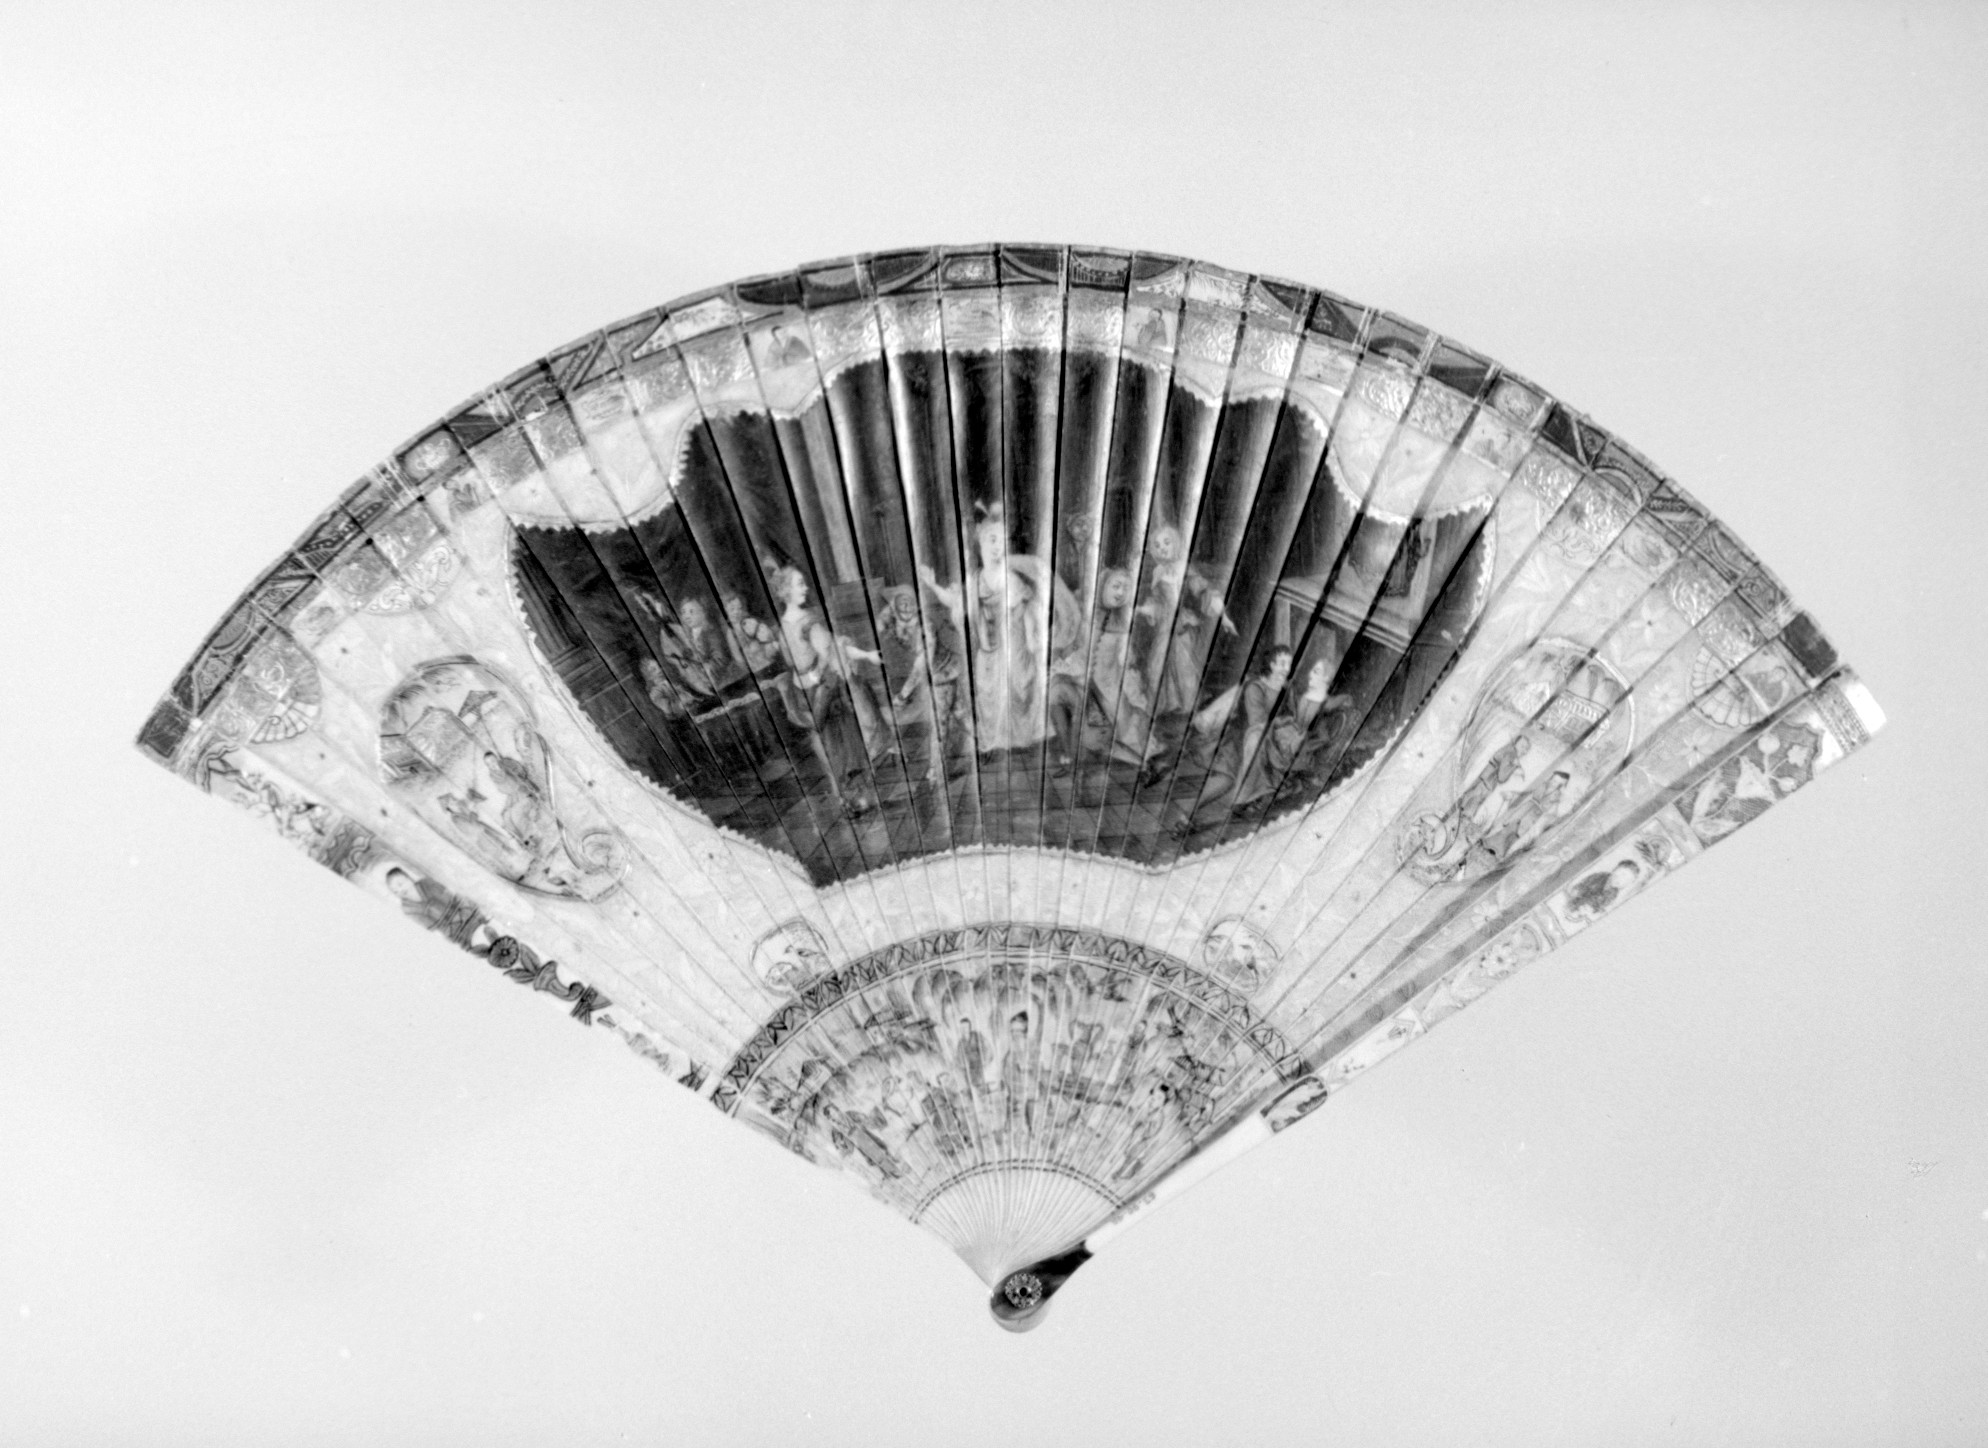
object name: fan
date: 1701-1800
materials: ivory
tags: women